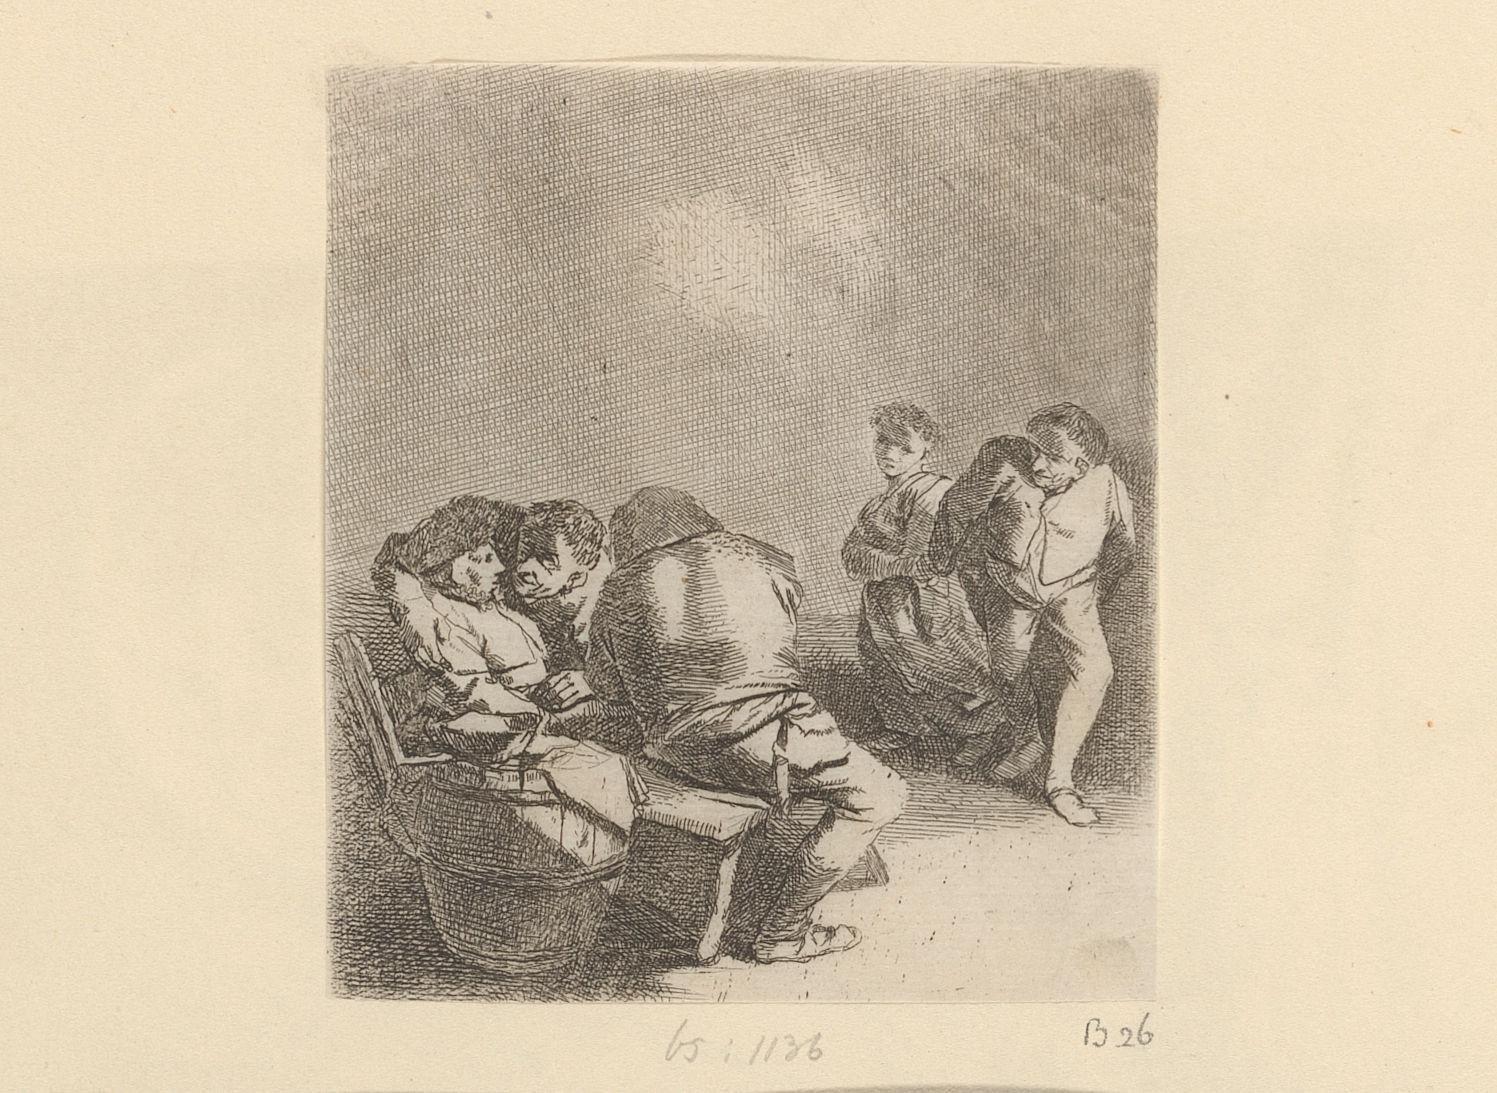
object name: album leaf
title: Vijf figuren in een herberg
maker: cornelis pietersz. bega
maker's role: draughtsman, painter, print maker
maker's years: 1631-1664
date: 1641-1664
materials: paper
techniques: engraving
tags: hotel, hostelry, inn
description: Prent maakt mogelijk deel uit van een serie van 200 prenten. Deze serie is onder de titel 'A Collection of two hundred original etchings' voor het eerst uitgegeven door J.M. Greery in 1816.